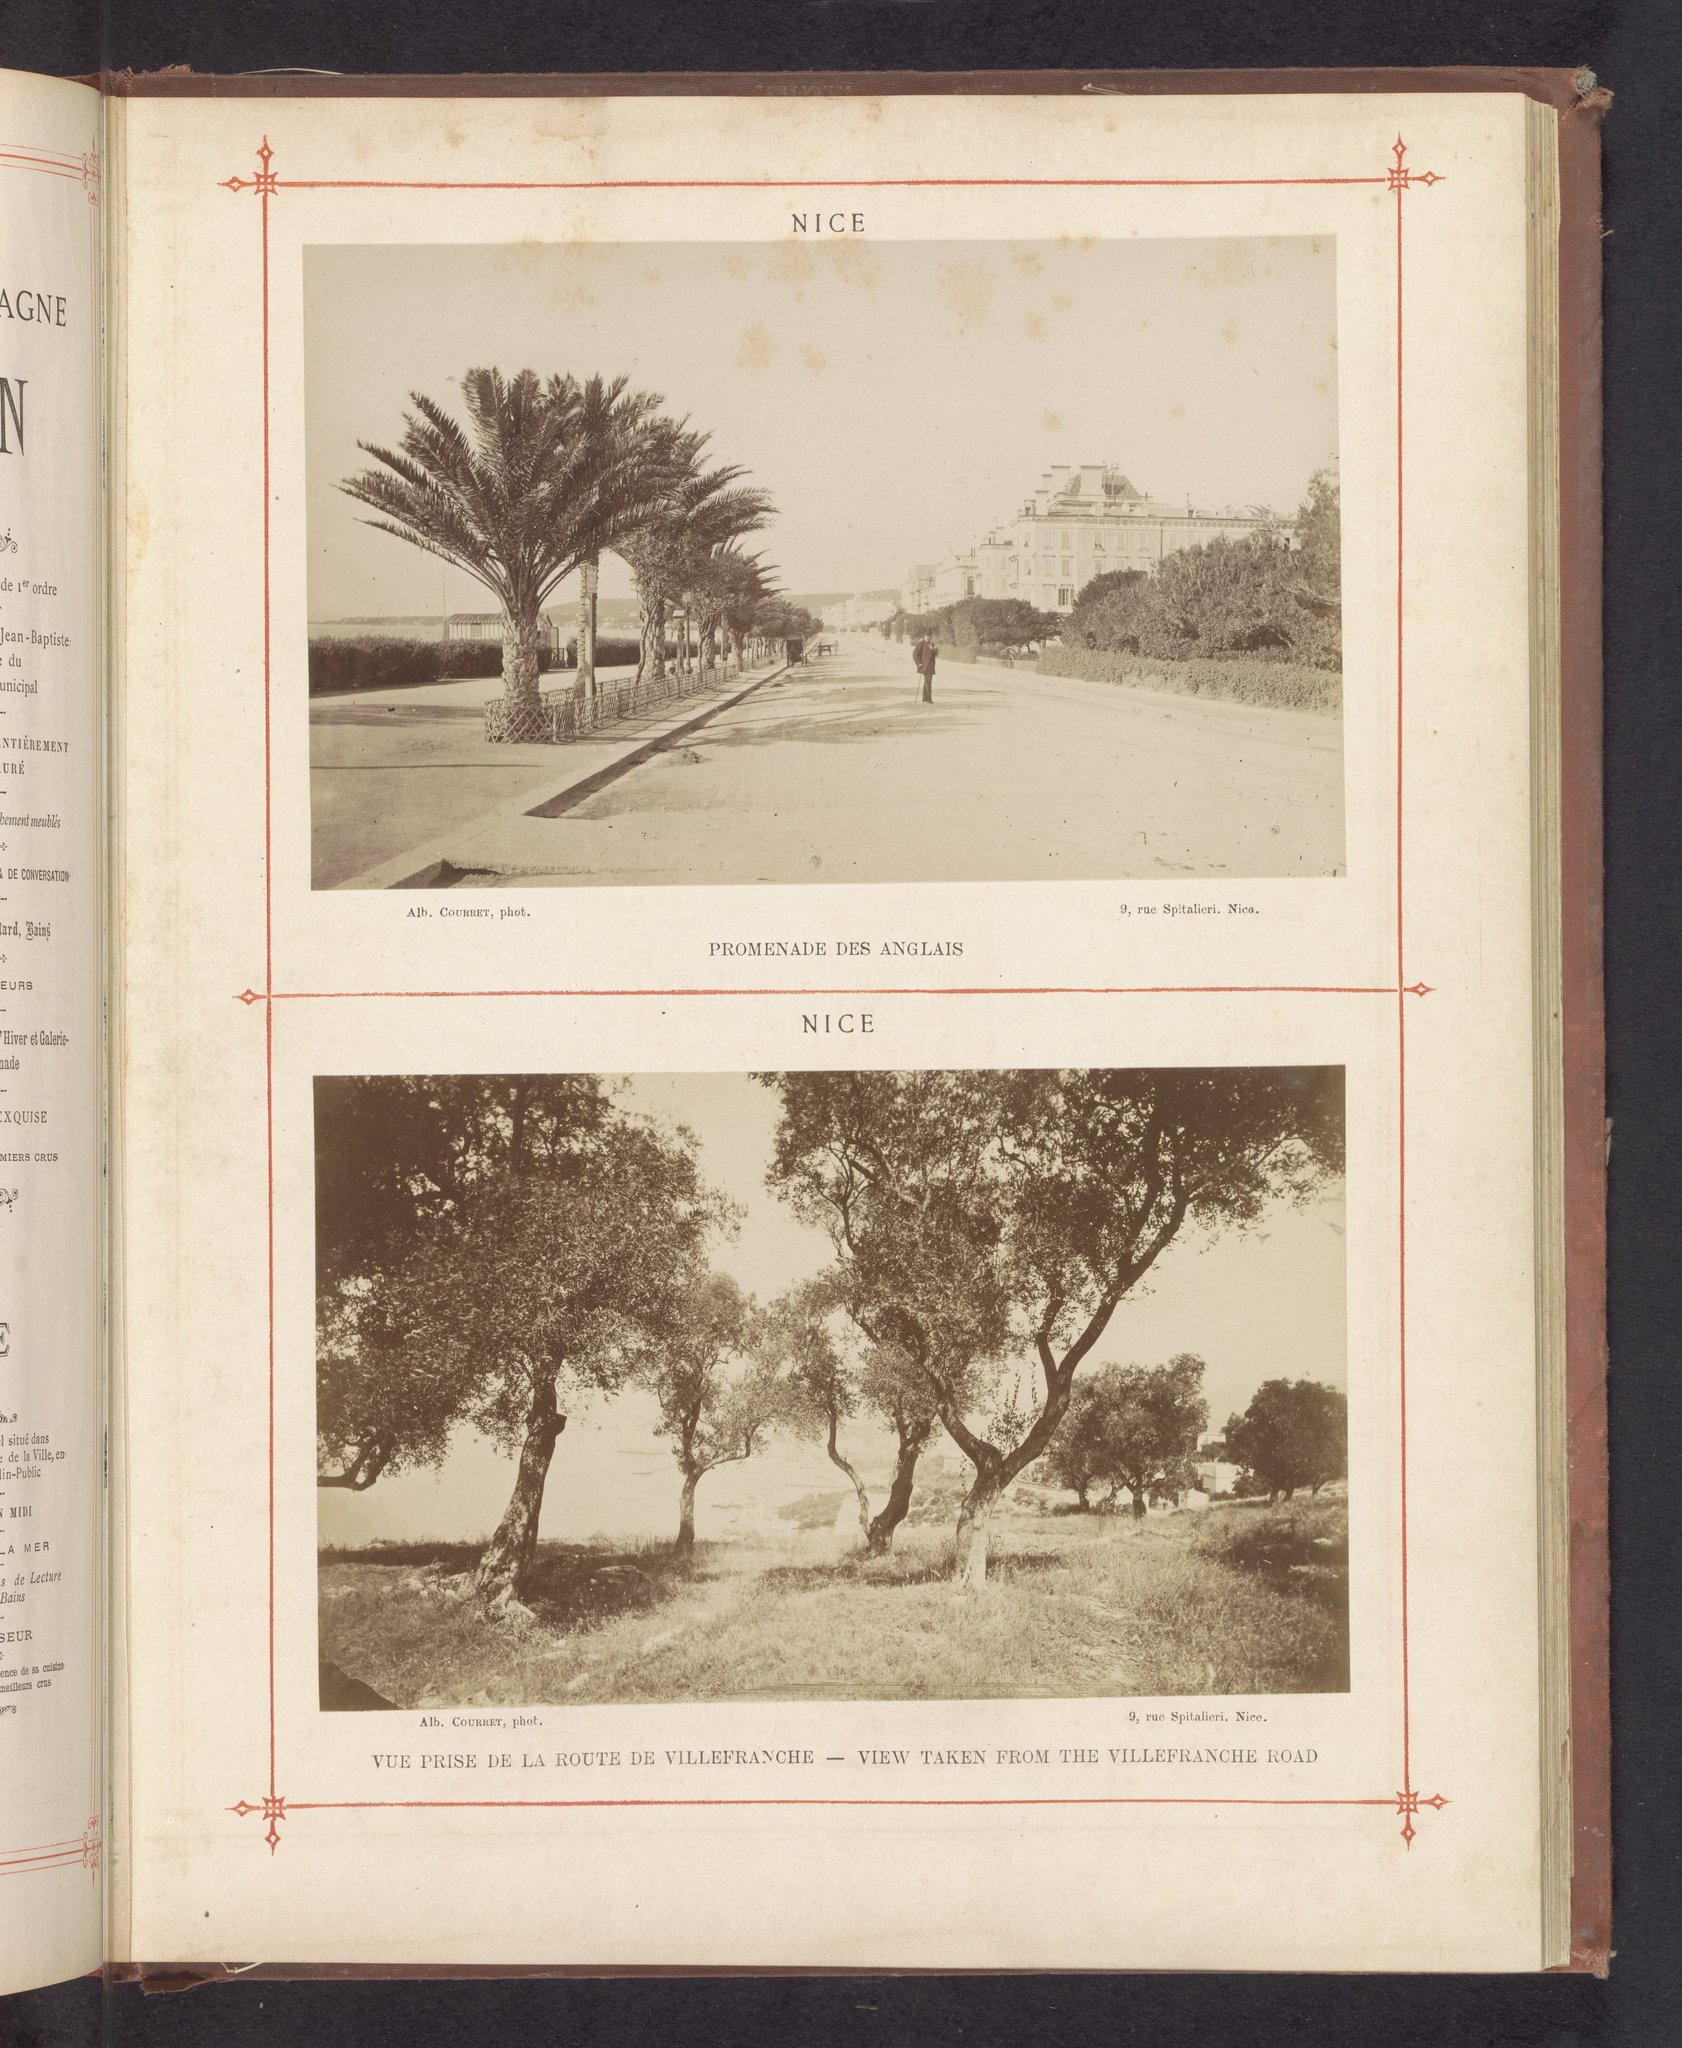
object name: page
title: View taken from the Villefranche road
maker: albert courret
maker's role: fotograaf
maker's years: 1856-1928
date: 1876-1886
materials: photographic support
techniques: albumen print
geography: nice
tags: city-view in general; 'veduta', avenue, boulevard, promenade, esplanade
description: Boven een gezicht op de Promenade des Anglais te Nice, onder een gezicht op Nice.